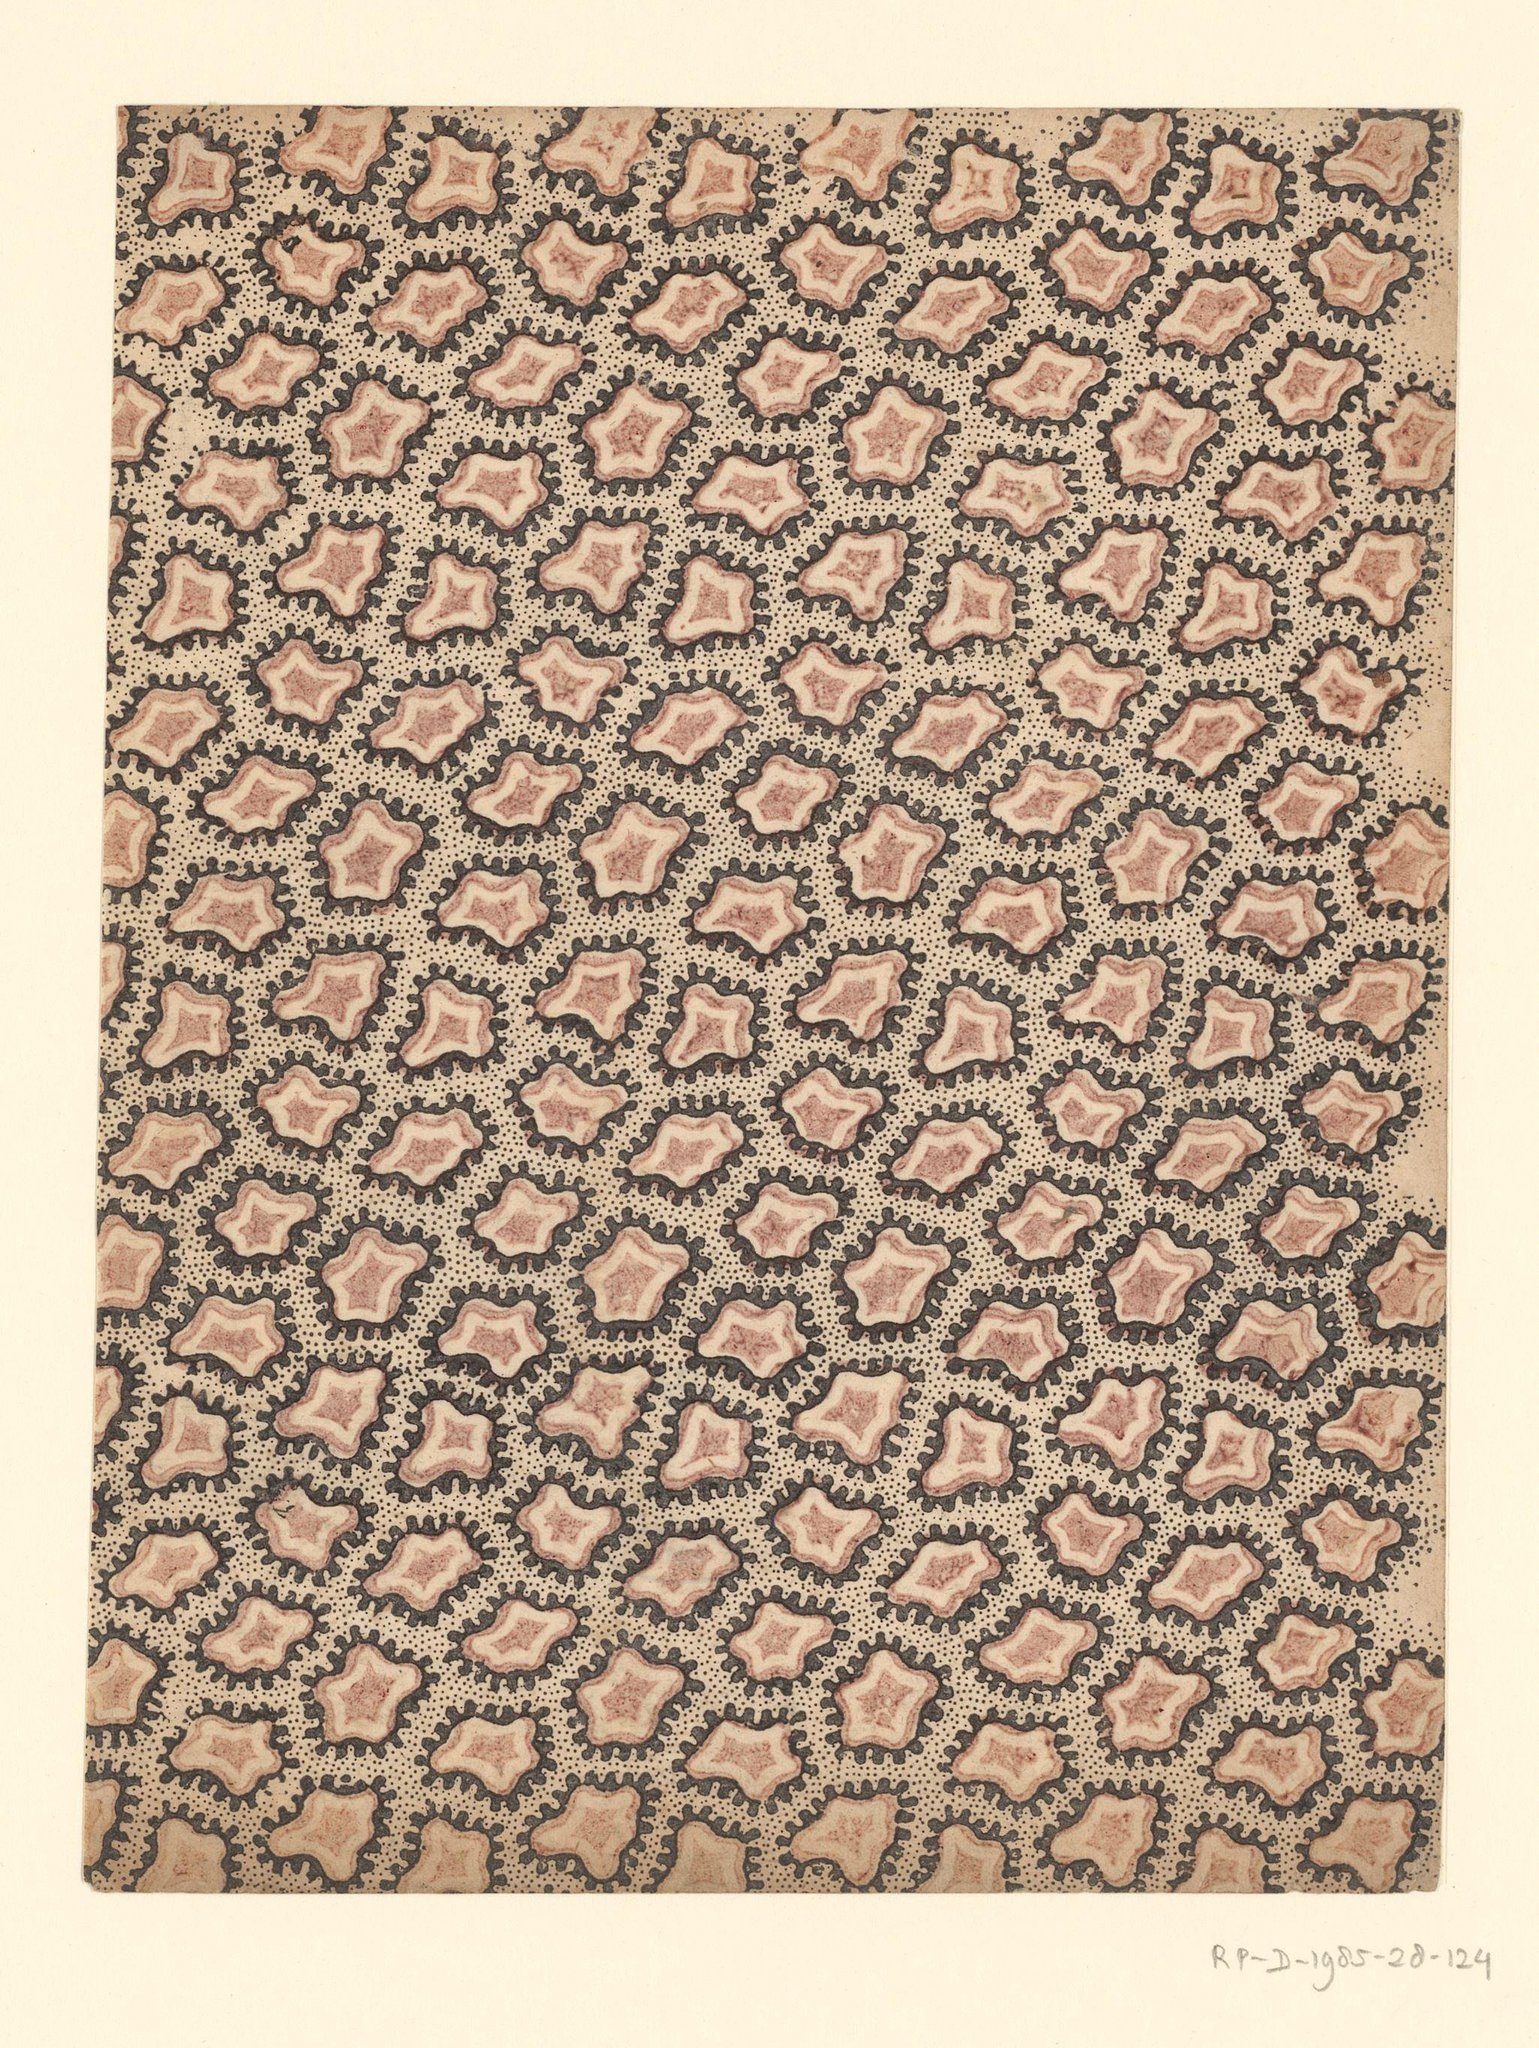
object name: printed paper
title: Blad met strooipatroon van rotsachtig motief op puntenfond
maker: Anonymous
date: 1750-1900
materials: paper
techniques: printing block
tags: fantasy ornament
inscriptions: collector's mark: Lugt 2760, collector's mark: Lugt 2228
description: Blad met strooipatroon van rotsachtig motief met uitstulpingen op onderbroken puntenfond. Waarschijnlijk de helft van een omslag.